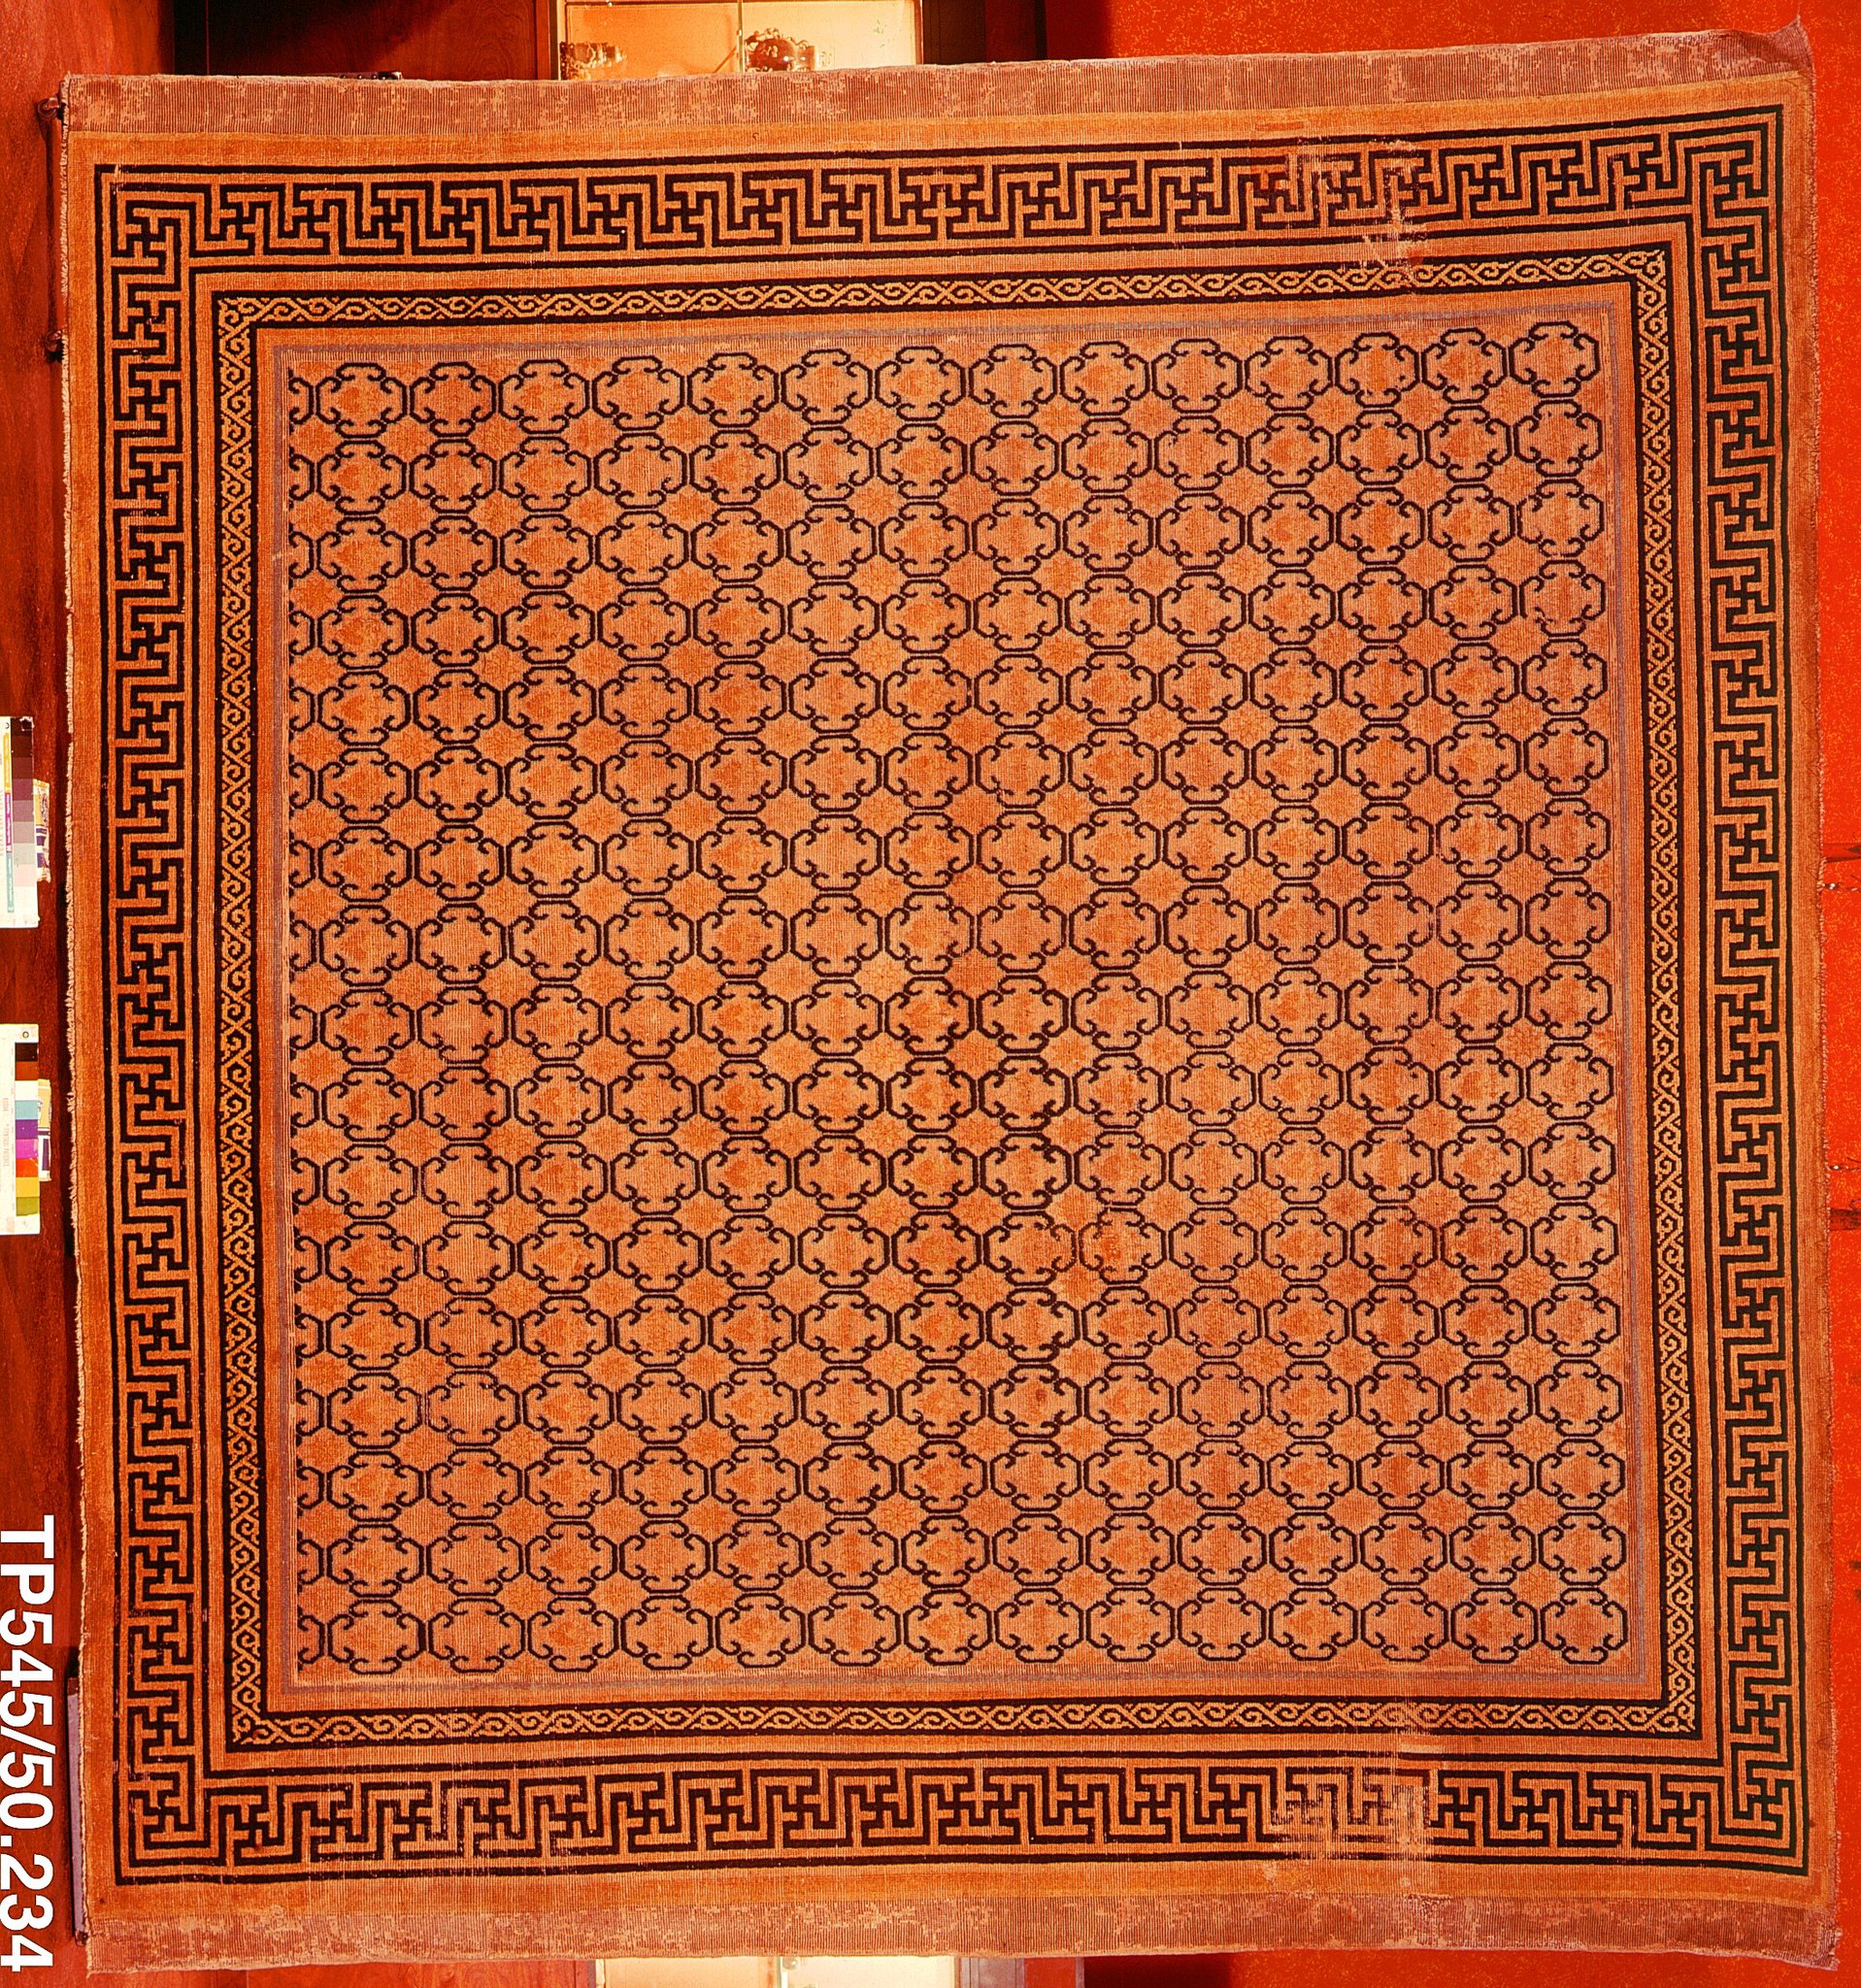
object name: rug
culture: chinese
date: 1601-1700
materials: cotton, wool